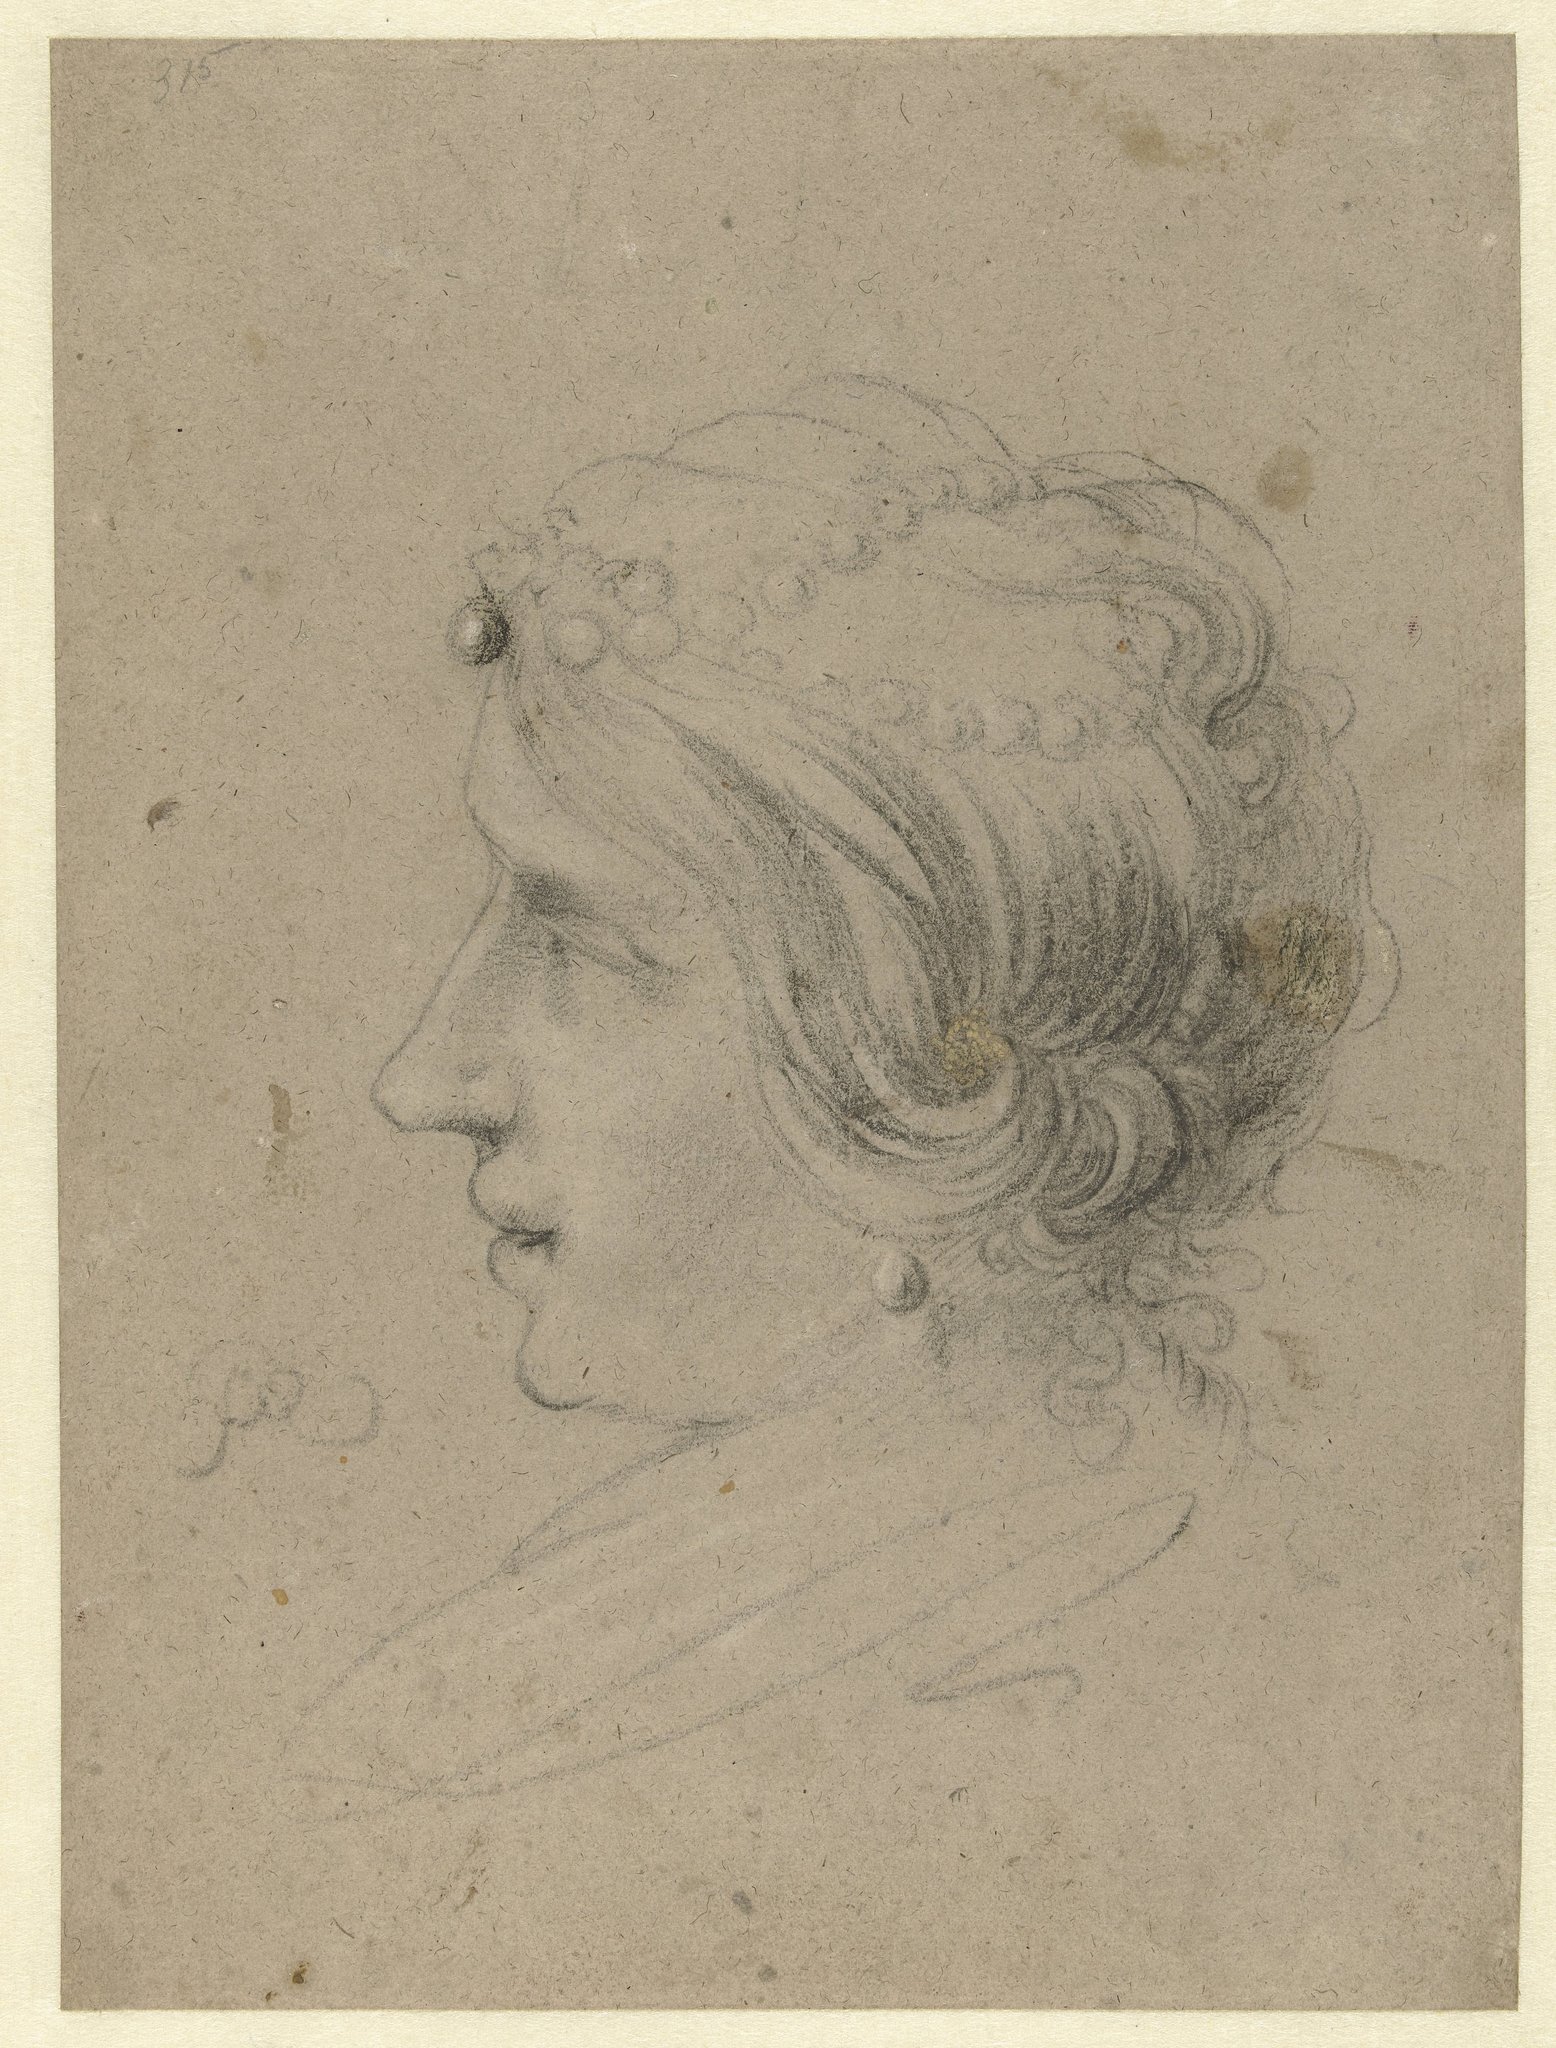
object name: drawing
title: Hoofd van een vrouw met een parelsnoer in het haar, en profiel, naar links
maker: pieter jansz quast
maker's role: draughtsman, painter, print maker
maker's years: 1605-1647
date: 1616-1647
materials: chalk, paper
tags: female sex; woman, head (human) - aa - female human figure